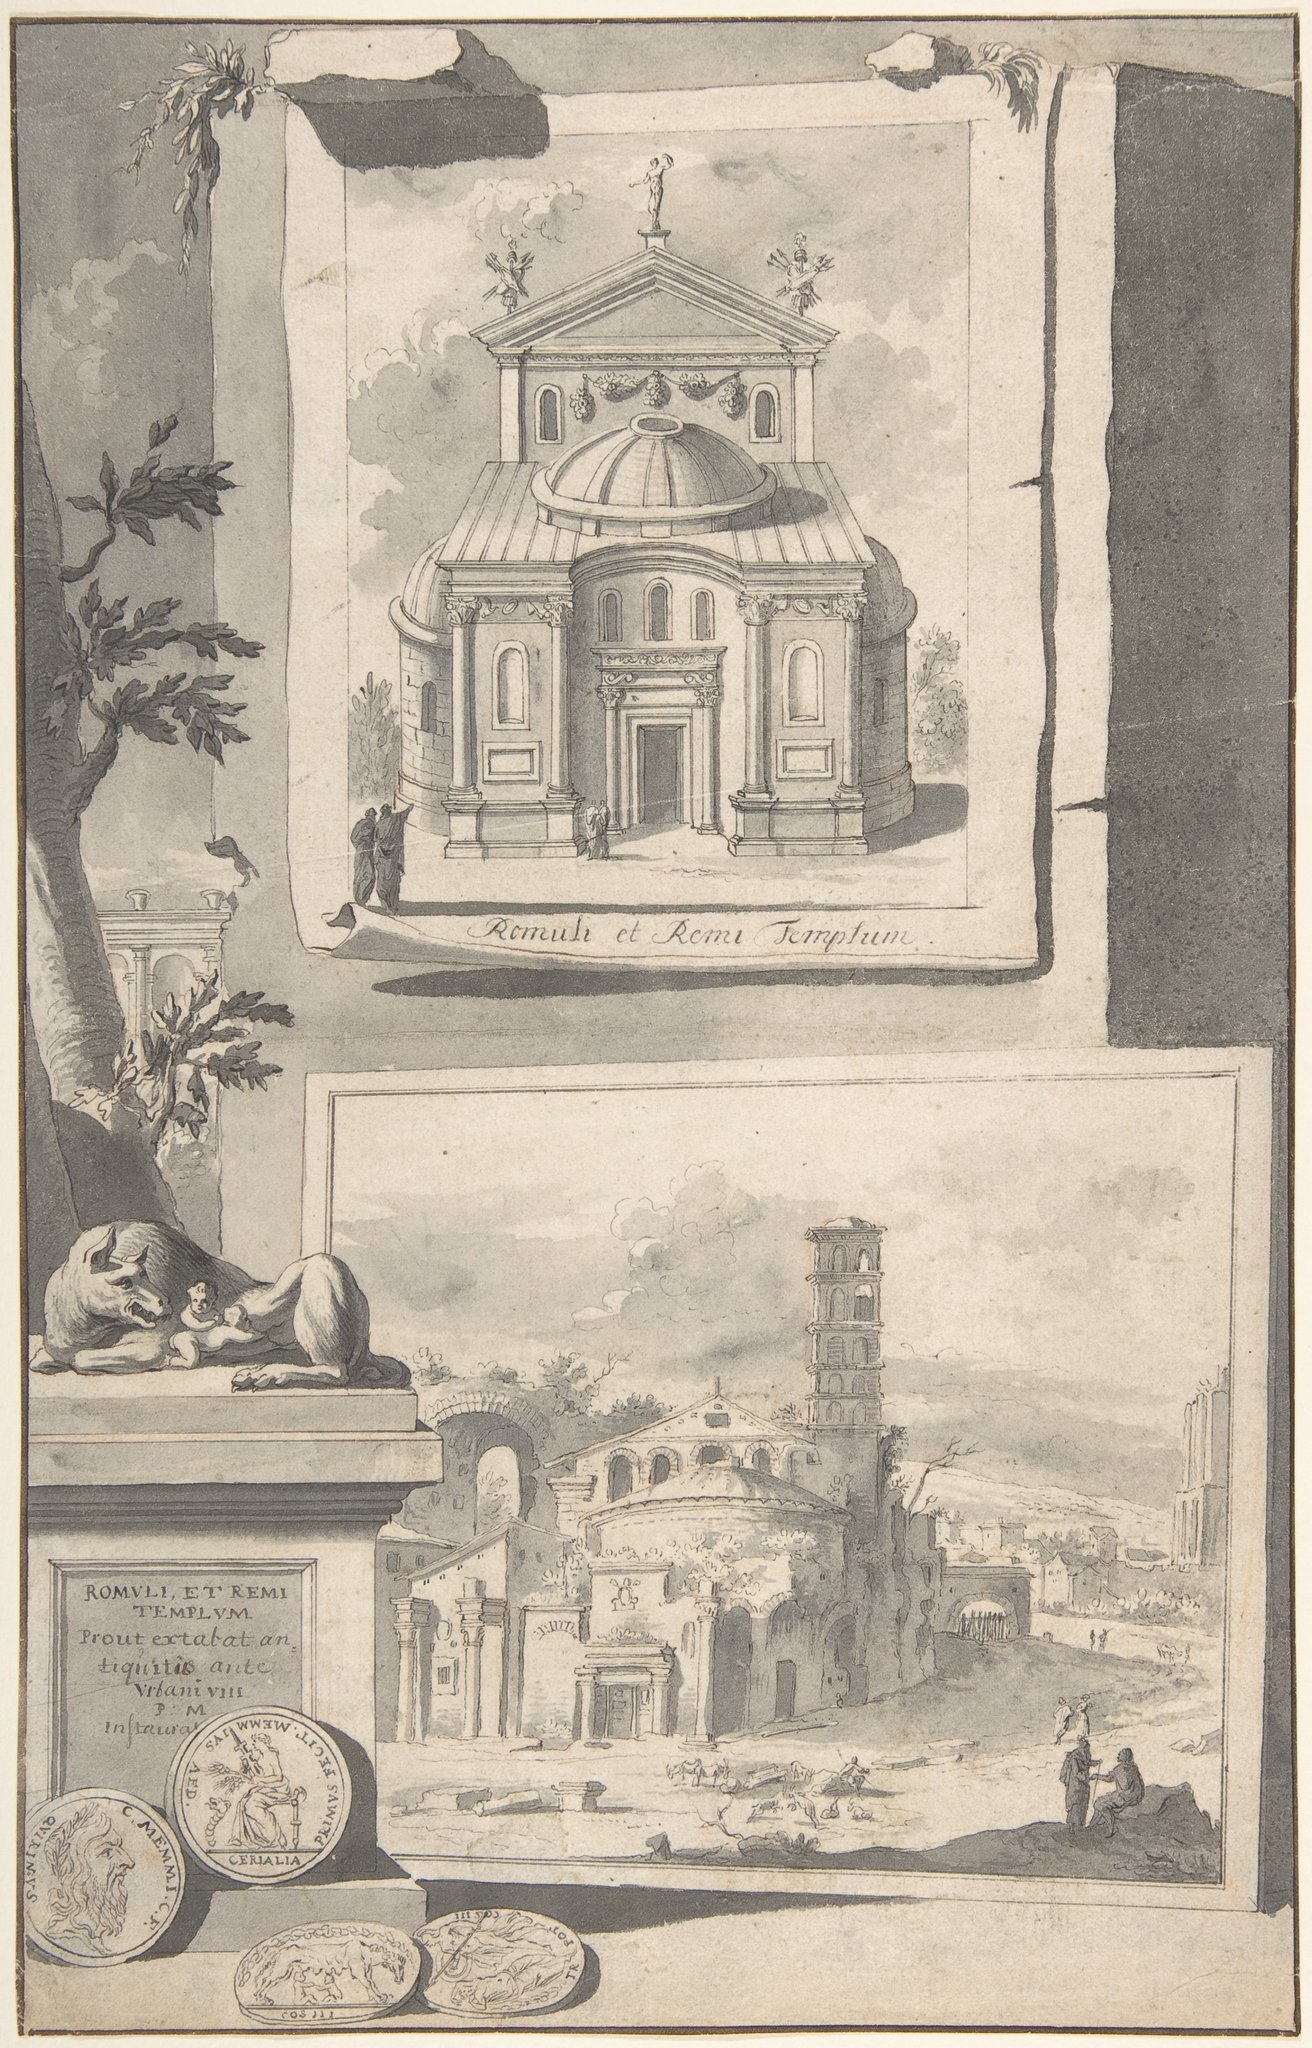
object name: drawing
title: A Reconstruction of the Temple of Romulus and Remus (above) and a View of the Ruins (below)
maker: jan goeree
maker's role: artist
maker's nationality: dutch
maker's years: 1670-1731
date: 1704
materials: chalk, ink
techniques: brush, pen, wash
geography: italy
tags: animals,architecture,temples,ruins